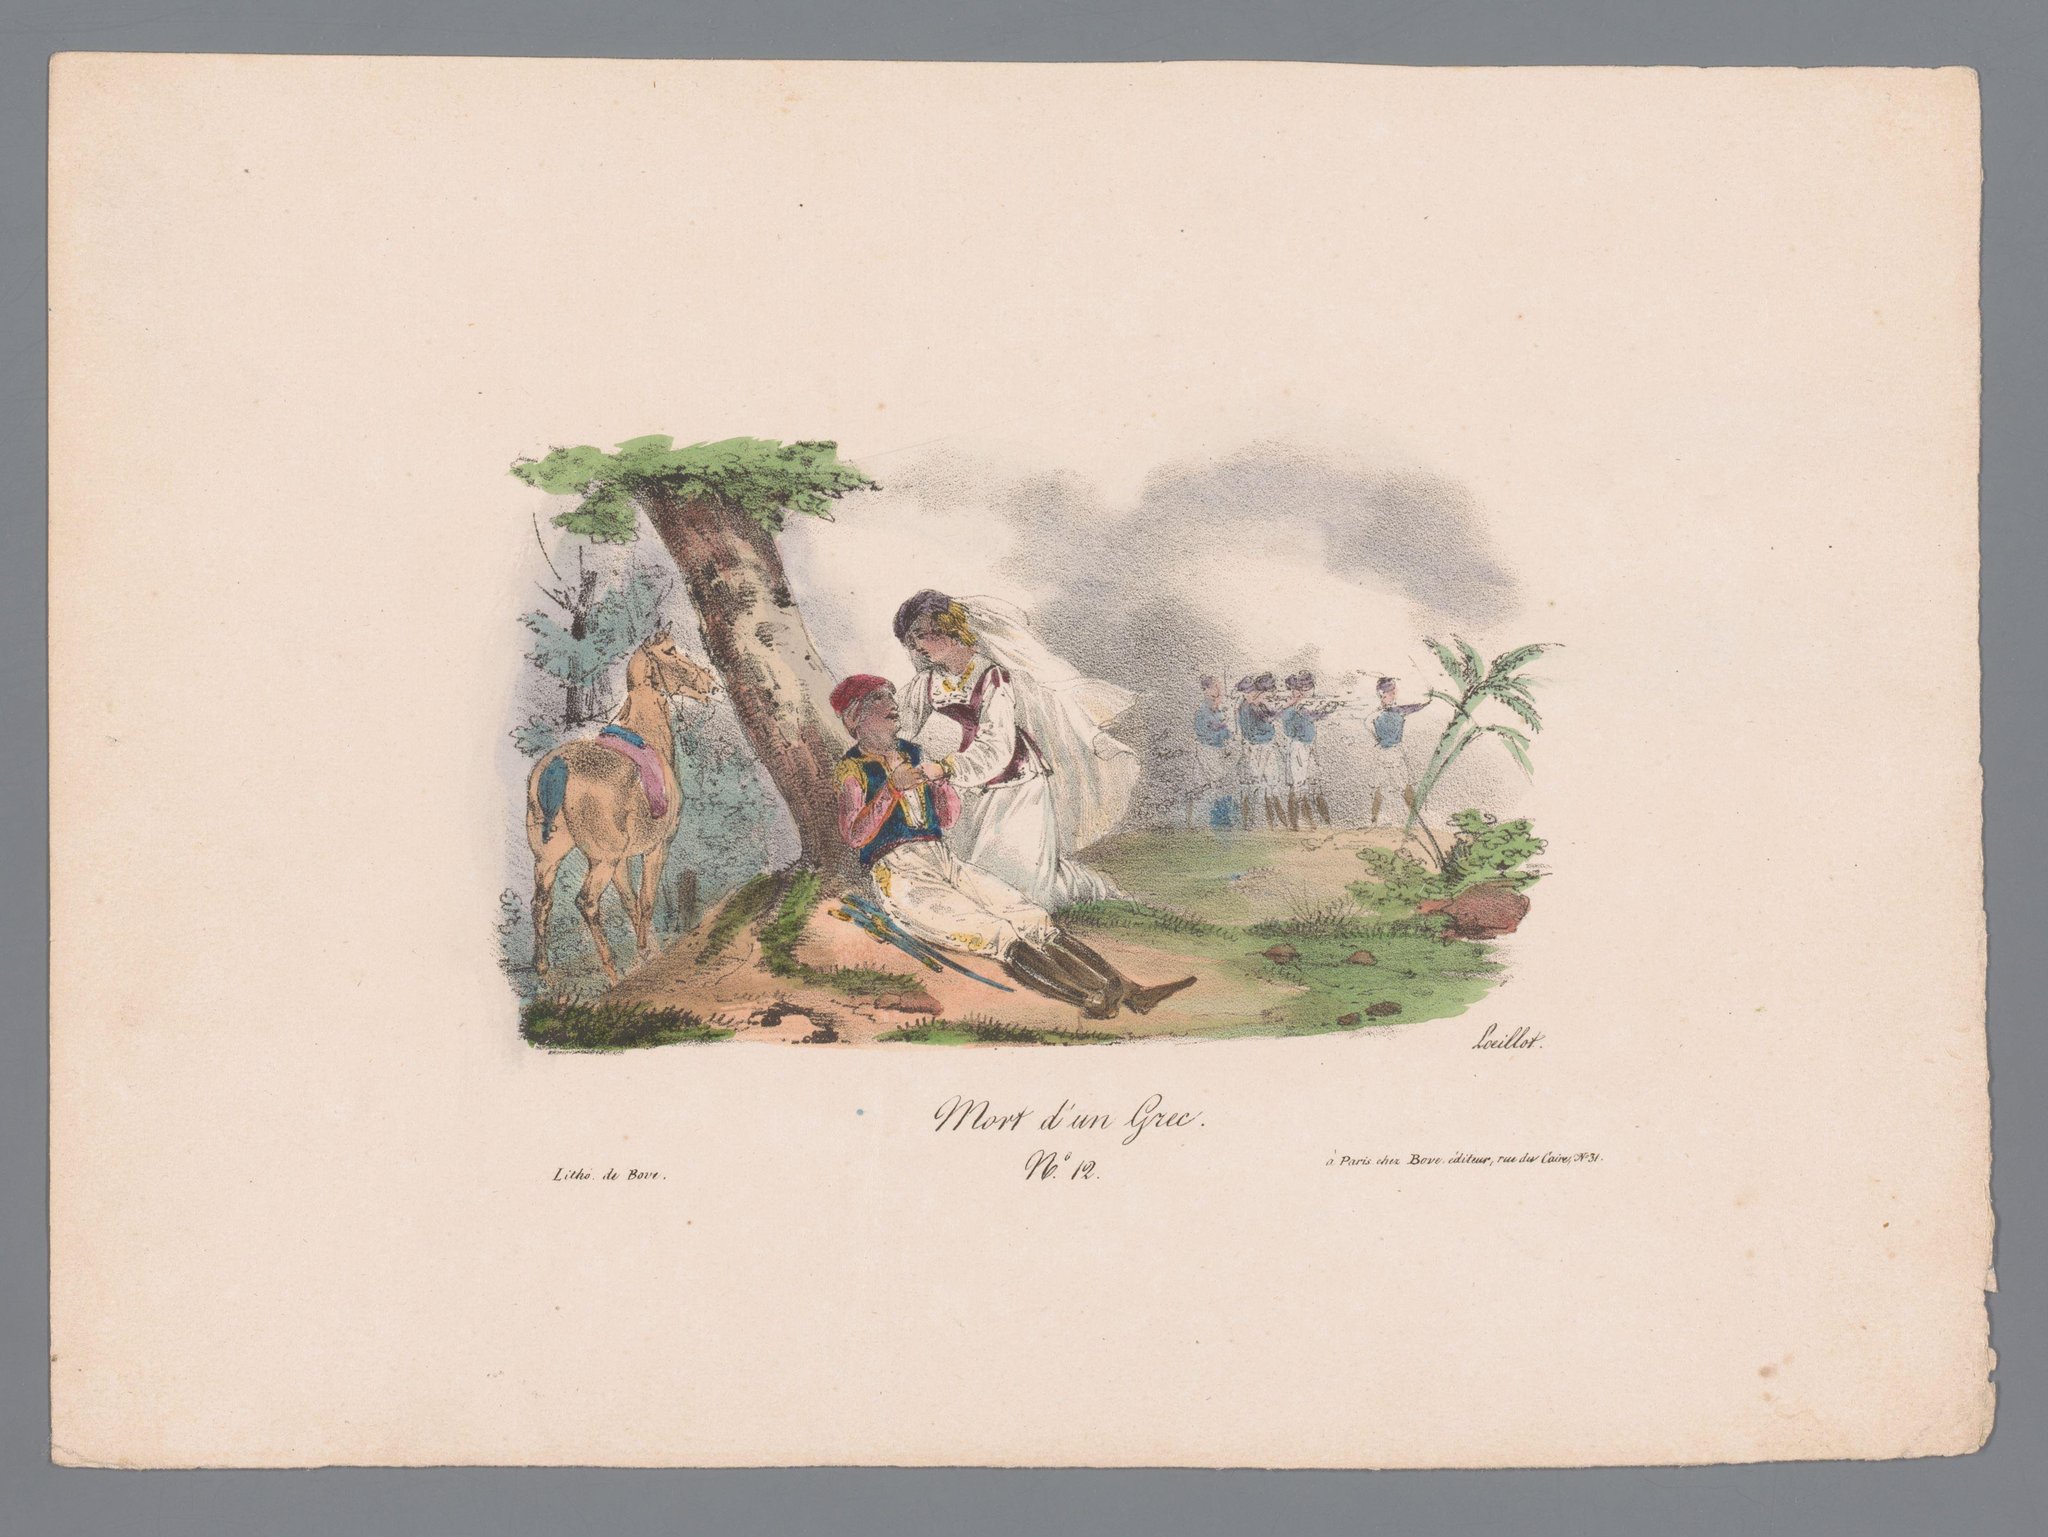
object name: print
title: Mort d'un Grec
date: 1829-1835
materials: paper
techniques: hand coloring, lithograph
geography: paris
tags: adult woman, trees (+ stem, trunk), dying, horse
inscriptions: collector's mark: Lugt 2228